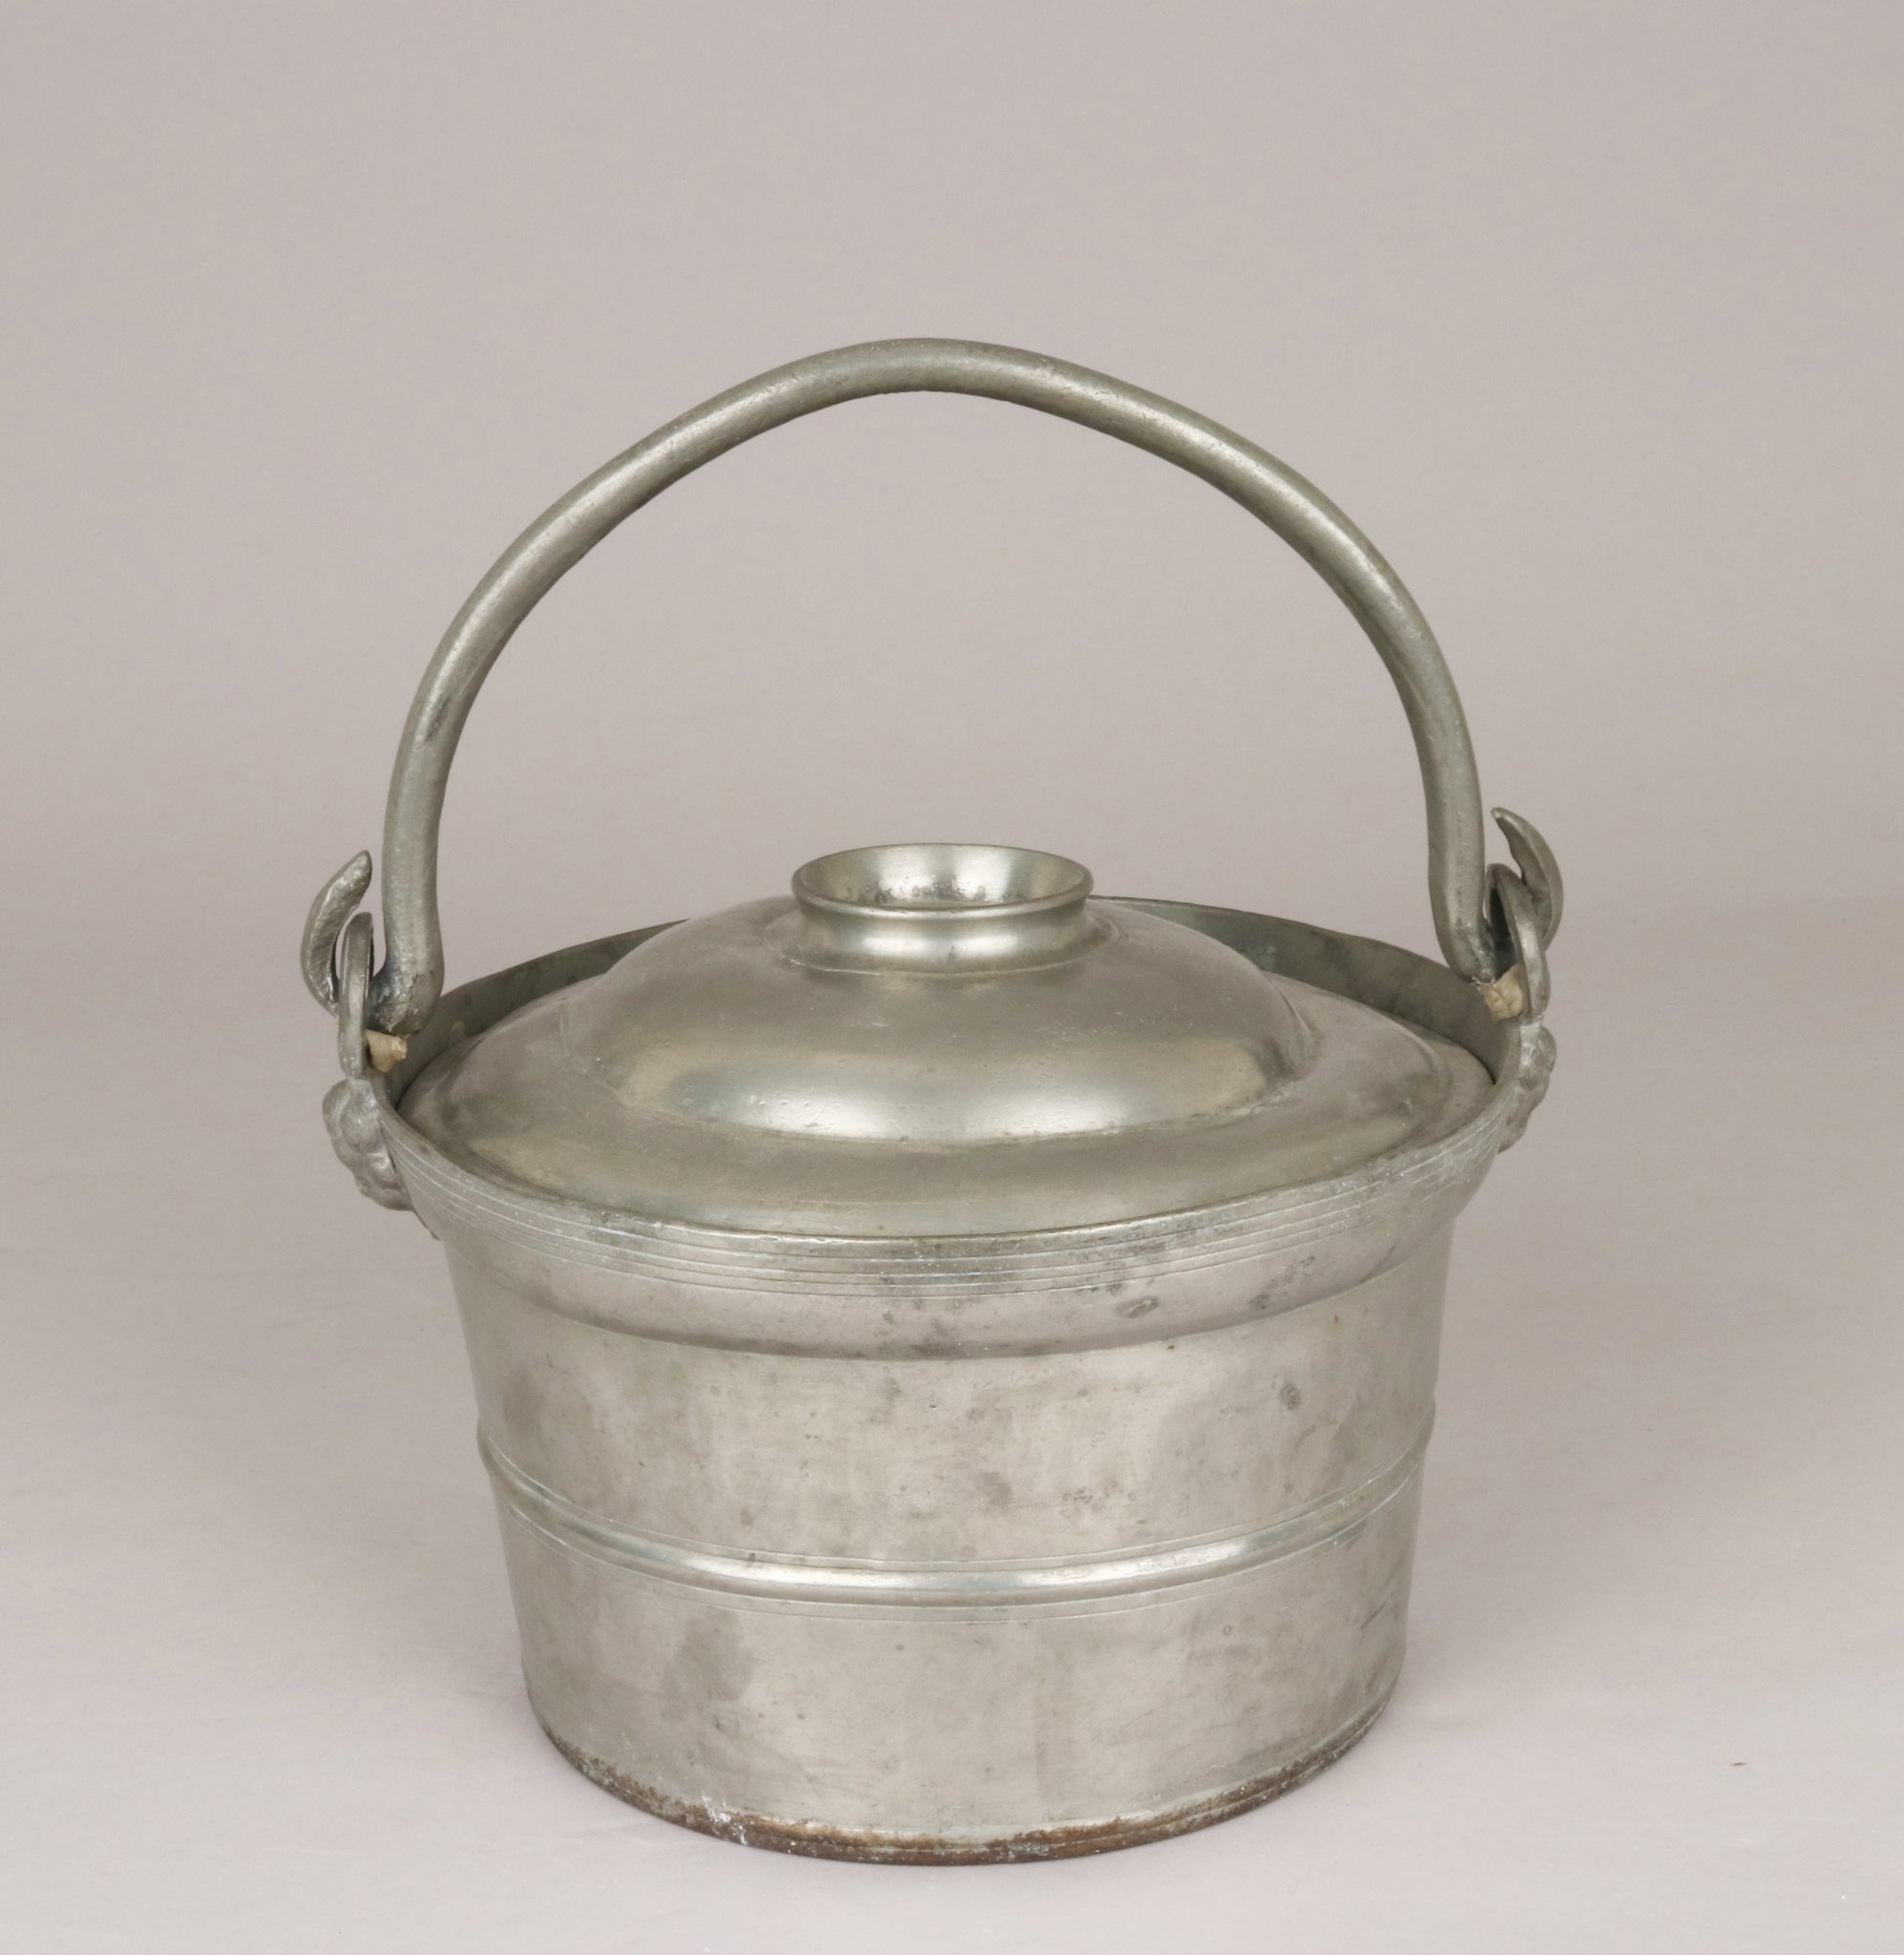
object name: dinner pail with cover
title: Dinner pail with cover (Porte-dîner)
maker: bouvier family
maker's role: maker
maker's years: 1623-1881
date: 1801-1900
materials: pewter